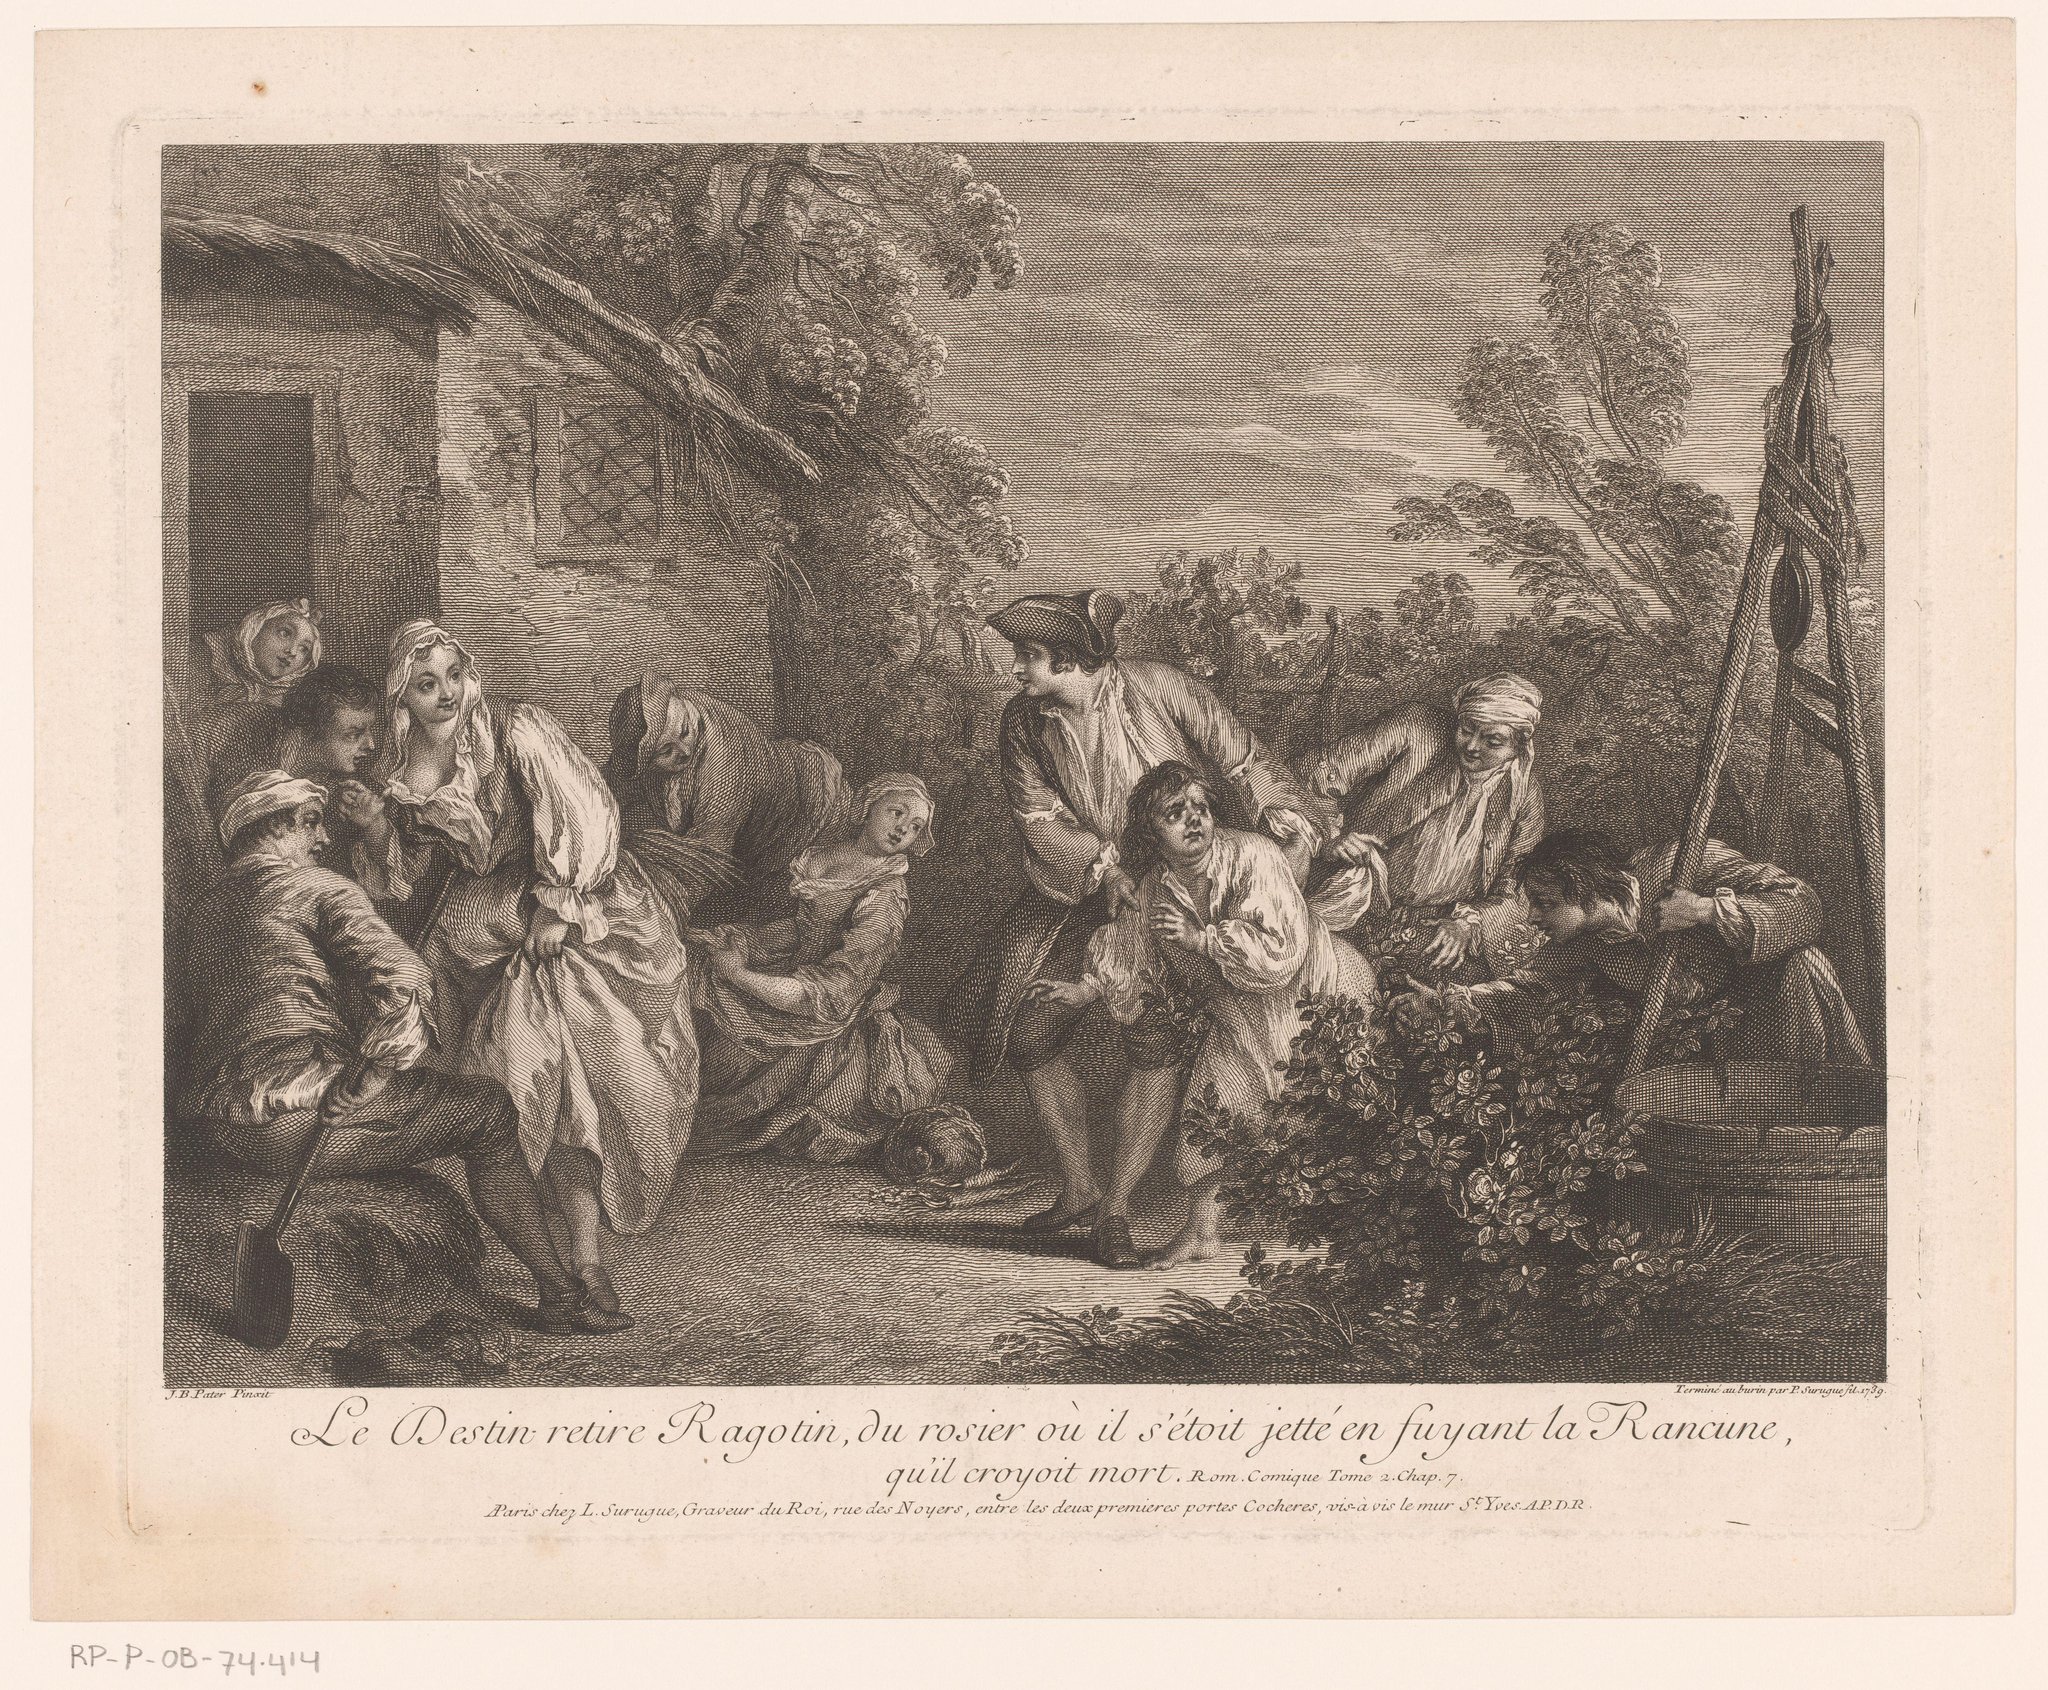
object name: print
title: Scènes uit de Roman Comique van Scarron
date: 1739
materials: paper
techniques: engraving, etching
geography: france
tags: (scarron, roman comique) specific works of literature (with author, title)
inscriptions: collector's mark: Lugt 2228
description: Serie van 16 prenten bij de Roman Comique van Scarron, waarvan een aantal door Louis en Pierre Louis Surugue.